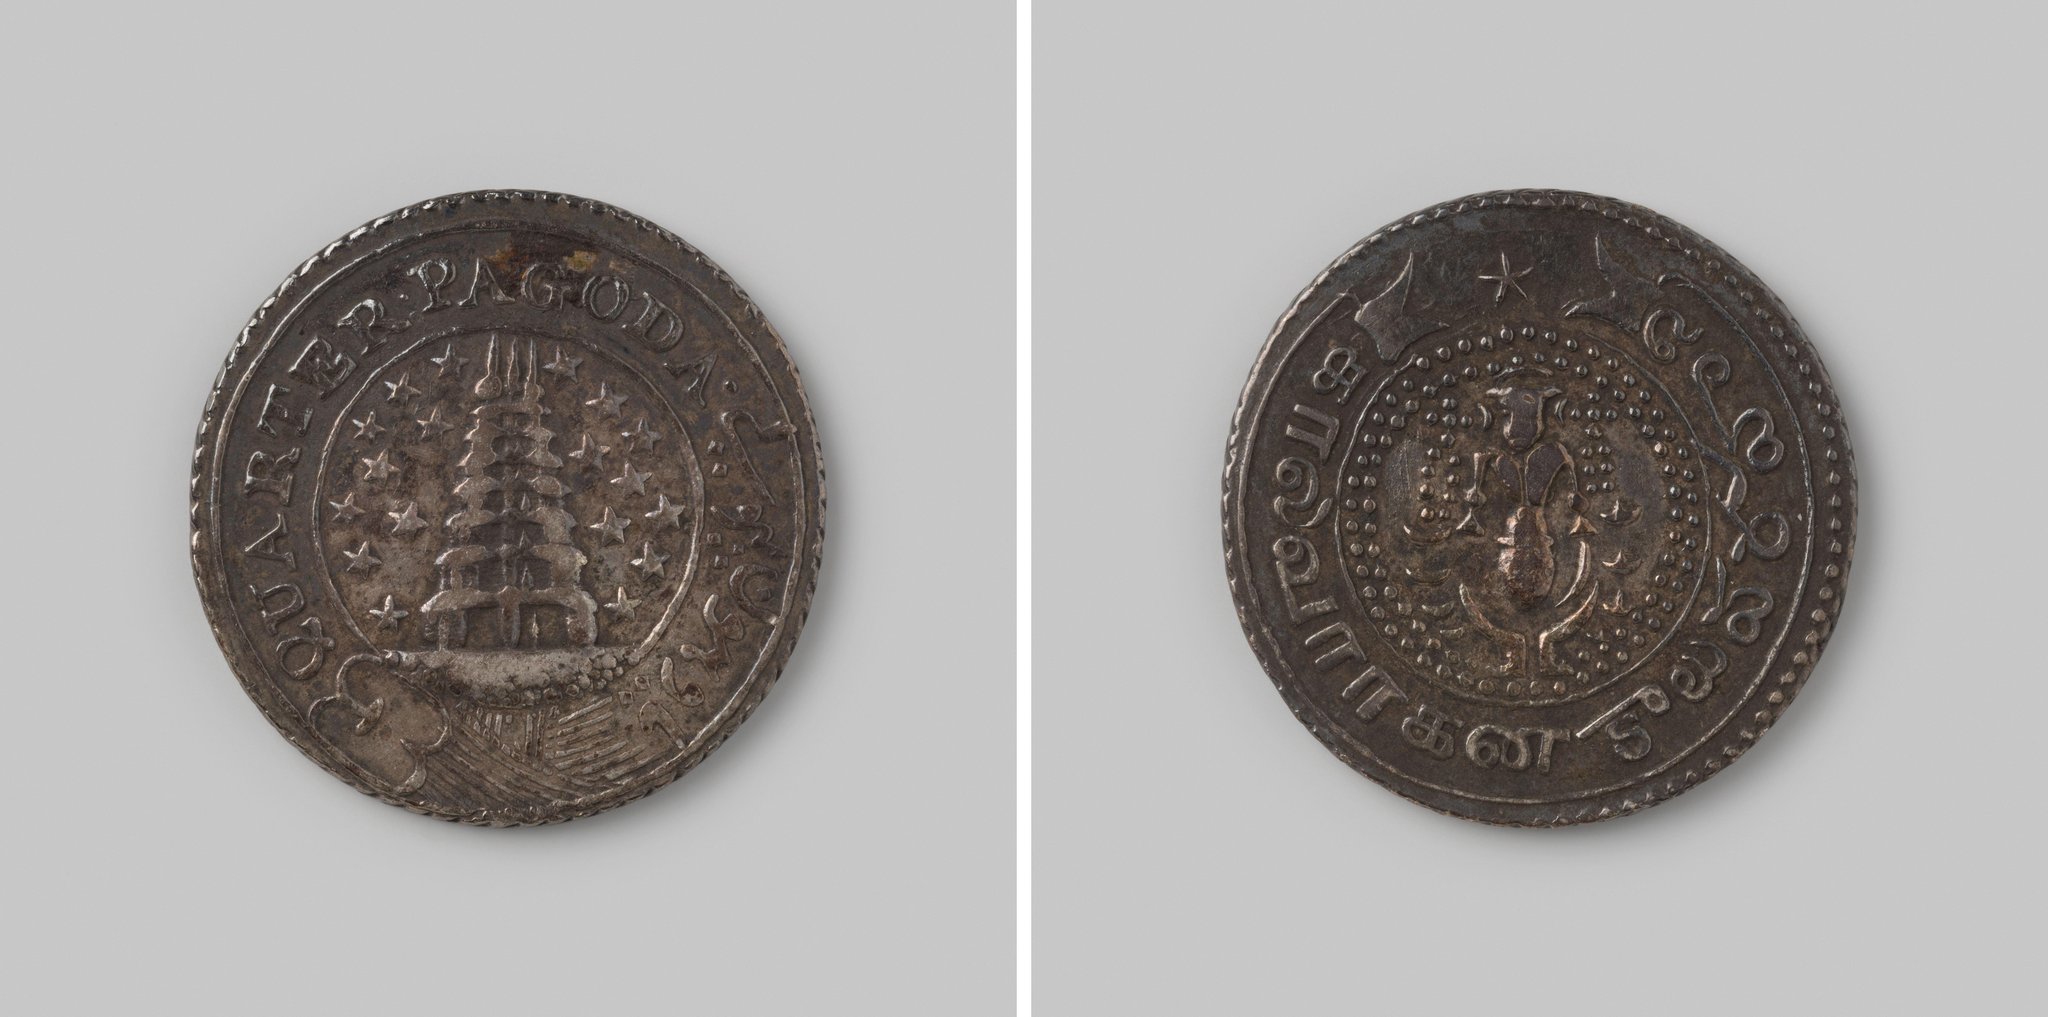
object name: coin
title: Madras, India, Engelse Oostindische Compagnie (EIC), 1/4 pagode, (1808)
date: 1808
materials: silver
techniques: striking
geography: chennai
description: Zilveren munt. Voorzijde: binnen cirkel, gevormd door ceintuur met gesp, tempelpoort, waaromheen sterren. Op gesp waarde-aanduiding in het Engels: quarter pagoda, en in Arabische lettertekens. Keerzijde: binnen cirkel, gevormd door lint, waarop waarde-aanduiding in het Tamil en in het Telugu, godheid ten halve lijve, staande, in een veld, bezaaid met korrels. Bovenaan, tussen uiteinden van het lint, een ster. Kabelrand.